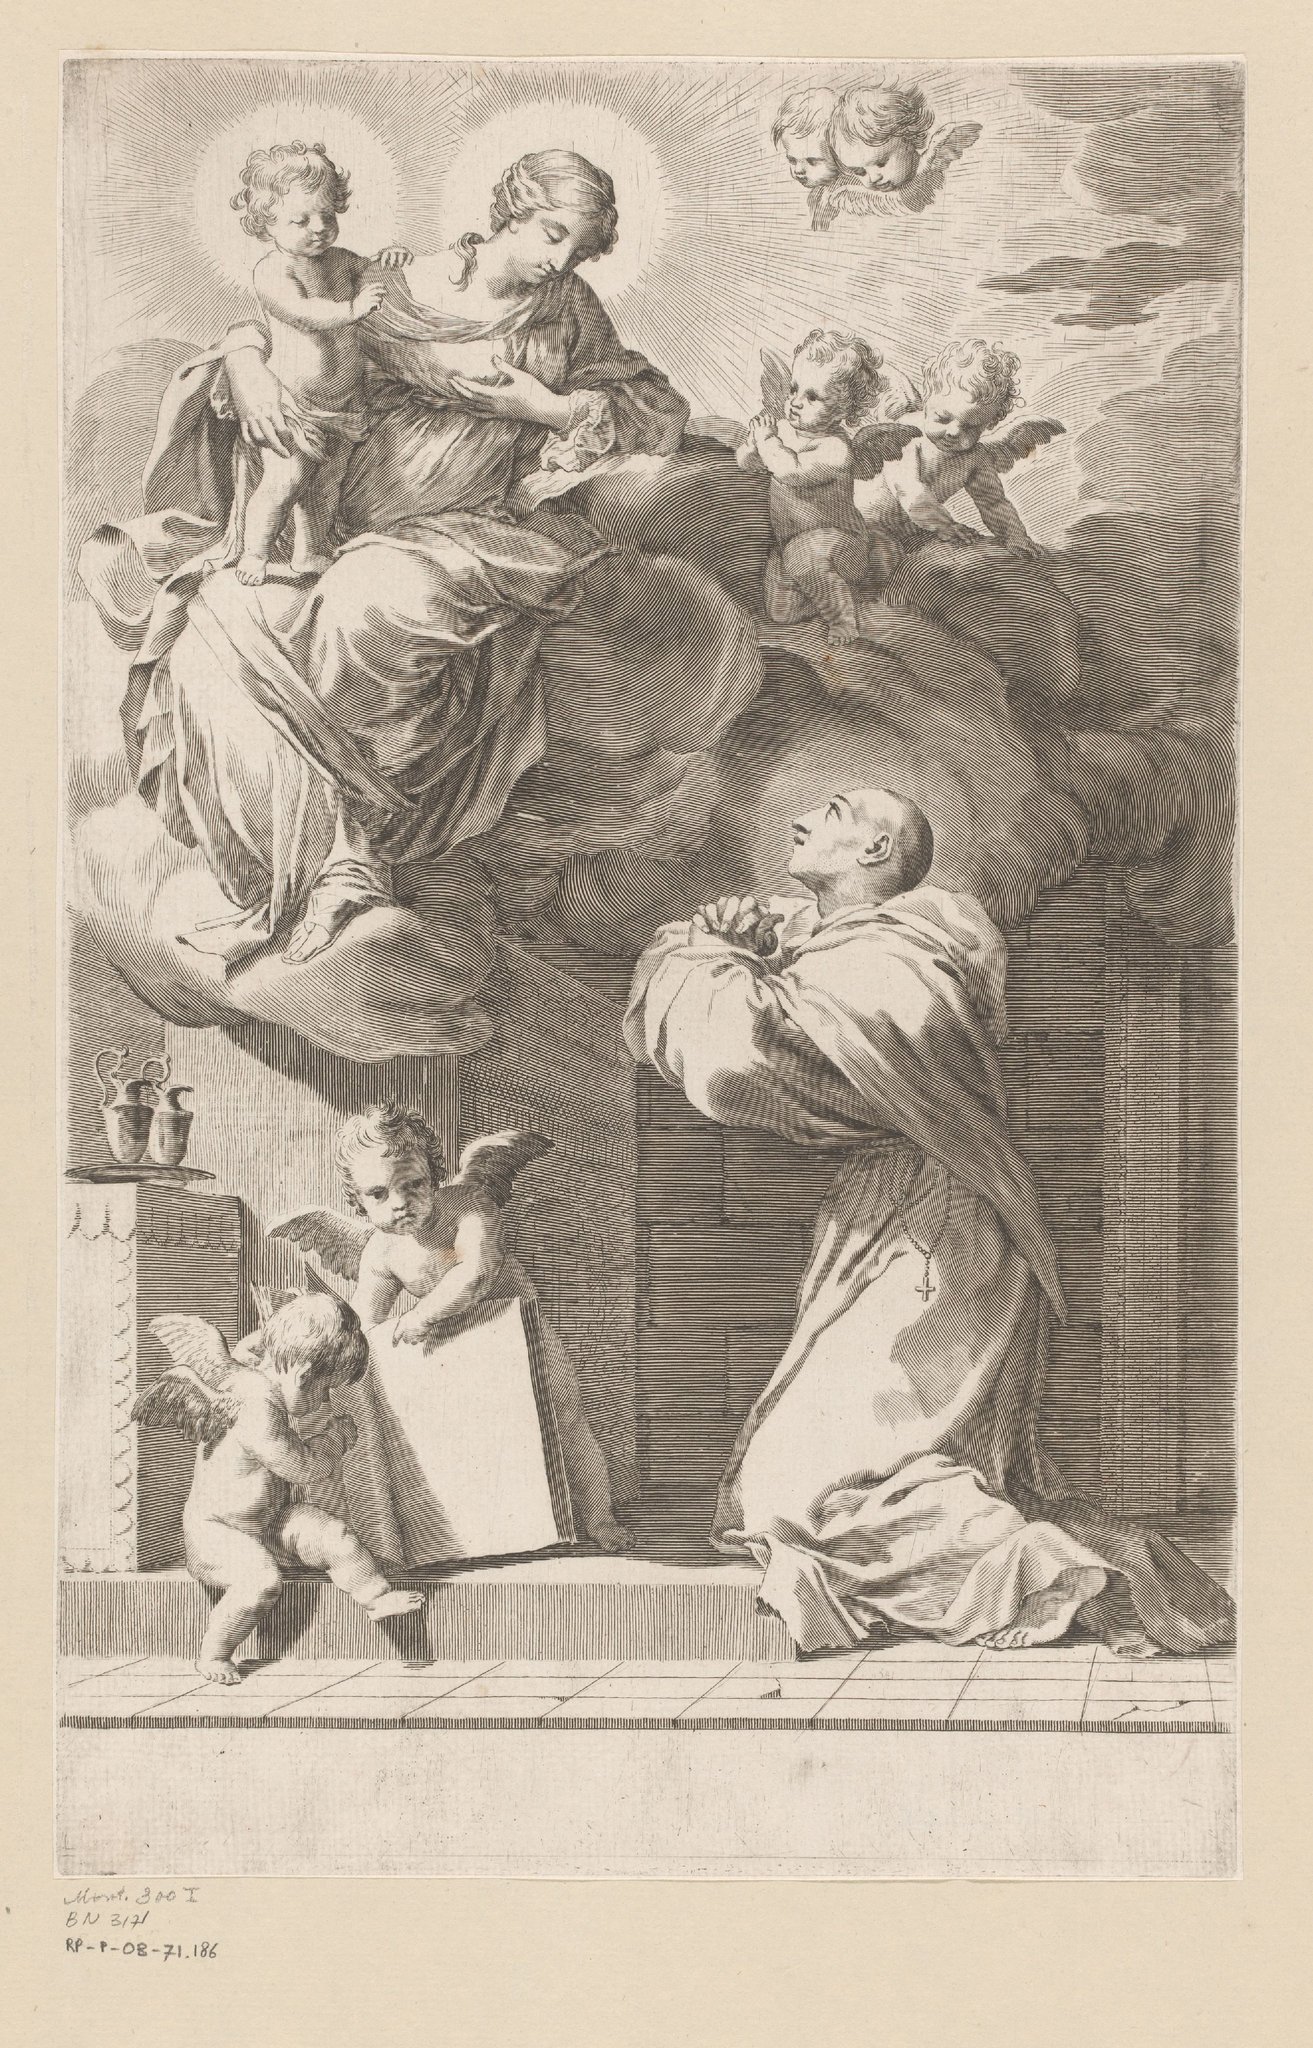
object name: titelblad, titelpagina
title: H. Bernard knielend voor een verschijning van Maria met Kind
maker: claude mellan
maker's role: draughtsman, print maker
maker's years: 1598-1688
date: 1640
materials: paper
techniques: engraving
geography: paris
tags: the virgin mary, making a teaching gesture, appears to st. bernard of clairvaux writing at his desk ('doctrina')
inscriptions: collector's mark: Lugt 240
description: Titelpagina voor: Bernard, Saint. Divi Bernardi Abbatis Claraevallis Operum. Parijs: Imprimerie Royale, 1640, dl. 1. De tekening door Stella bevindt zich in de bibliotheek van l'Istituto Nazionale di Archeologia e Storia dell'Arte te Rome.